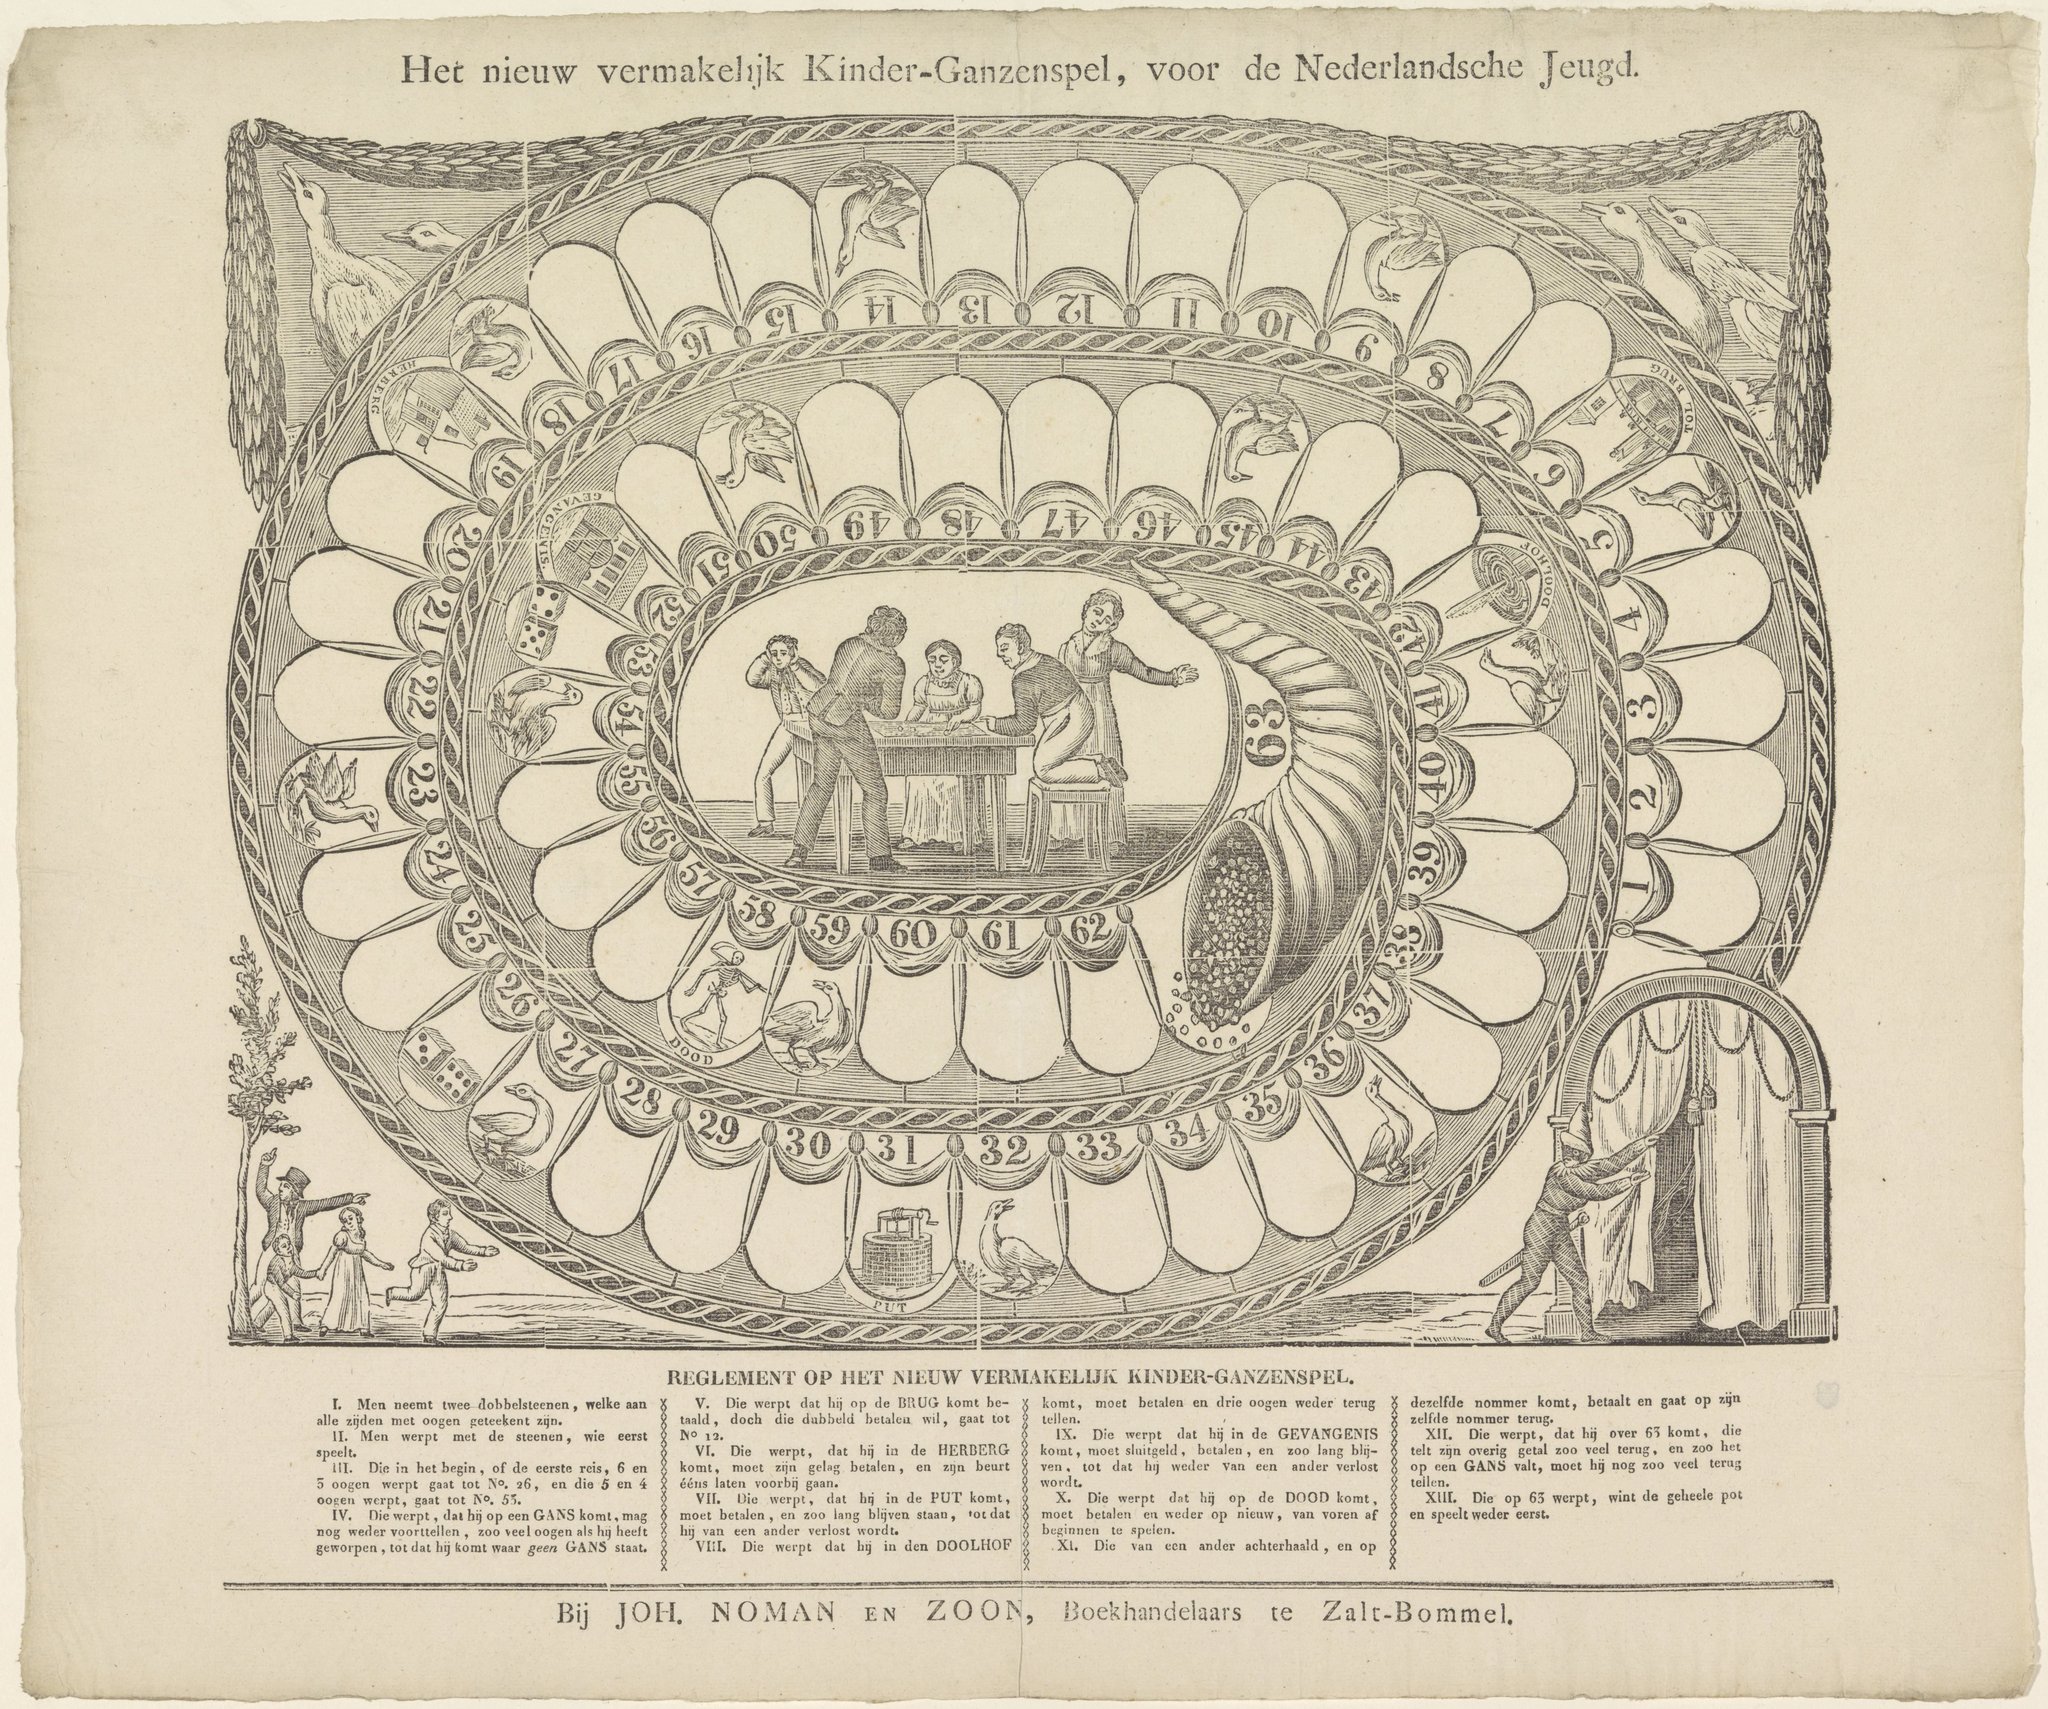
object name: game of goose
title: Het nieuw vermakelijk Kinder-Ganzenspel, voor de Nederlandsche jeugd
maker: Anonymous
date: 1840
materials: paper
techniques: letterpress printing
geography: zaltbommel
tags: goose-game, children's games and plays, board-games of chance, board-games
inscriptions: collector's mark: Lugt 2760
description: Ganzenbordspel met vakjes in een spiraal, genummerd van 1 tot en met 63. Op het middenveld een voorstelling van een groep kinderen staand rond een tafel die een spelletje ganzenbord speelt. In de hoeken kinderen, harlekijn en ganzen. In de ondermarge de spelregels in vier kolommen.